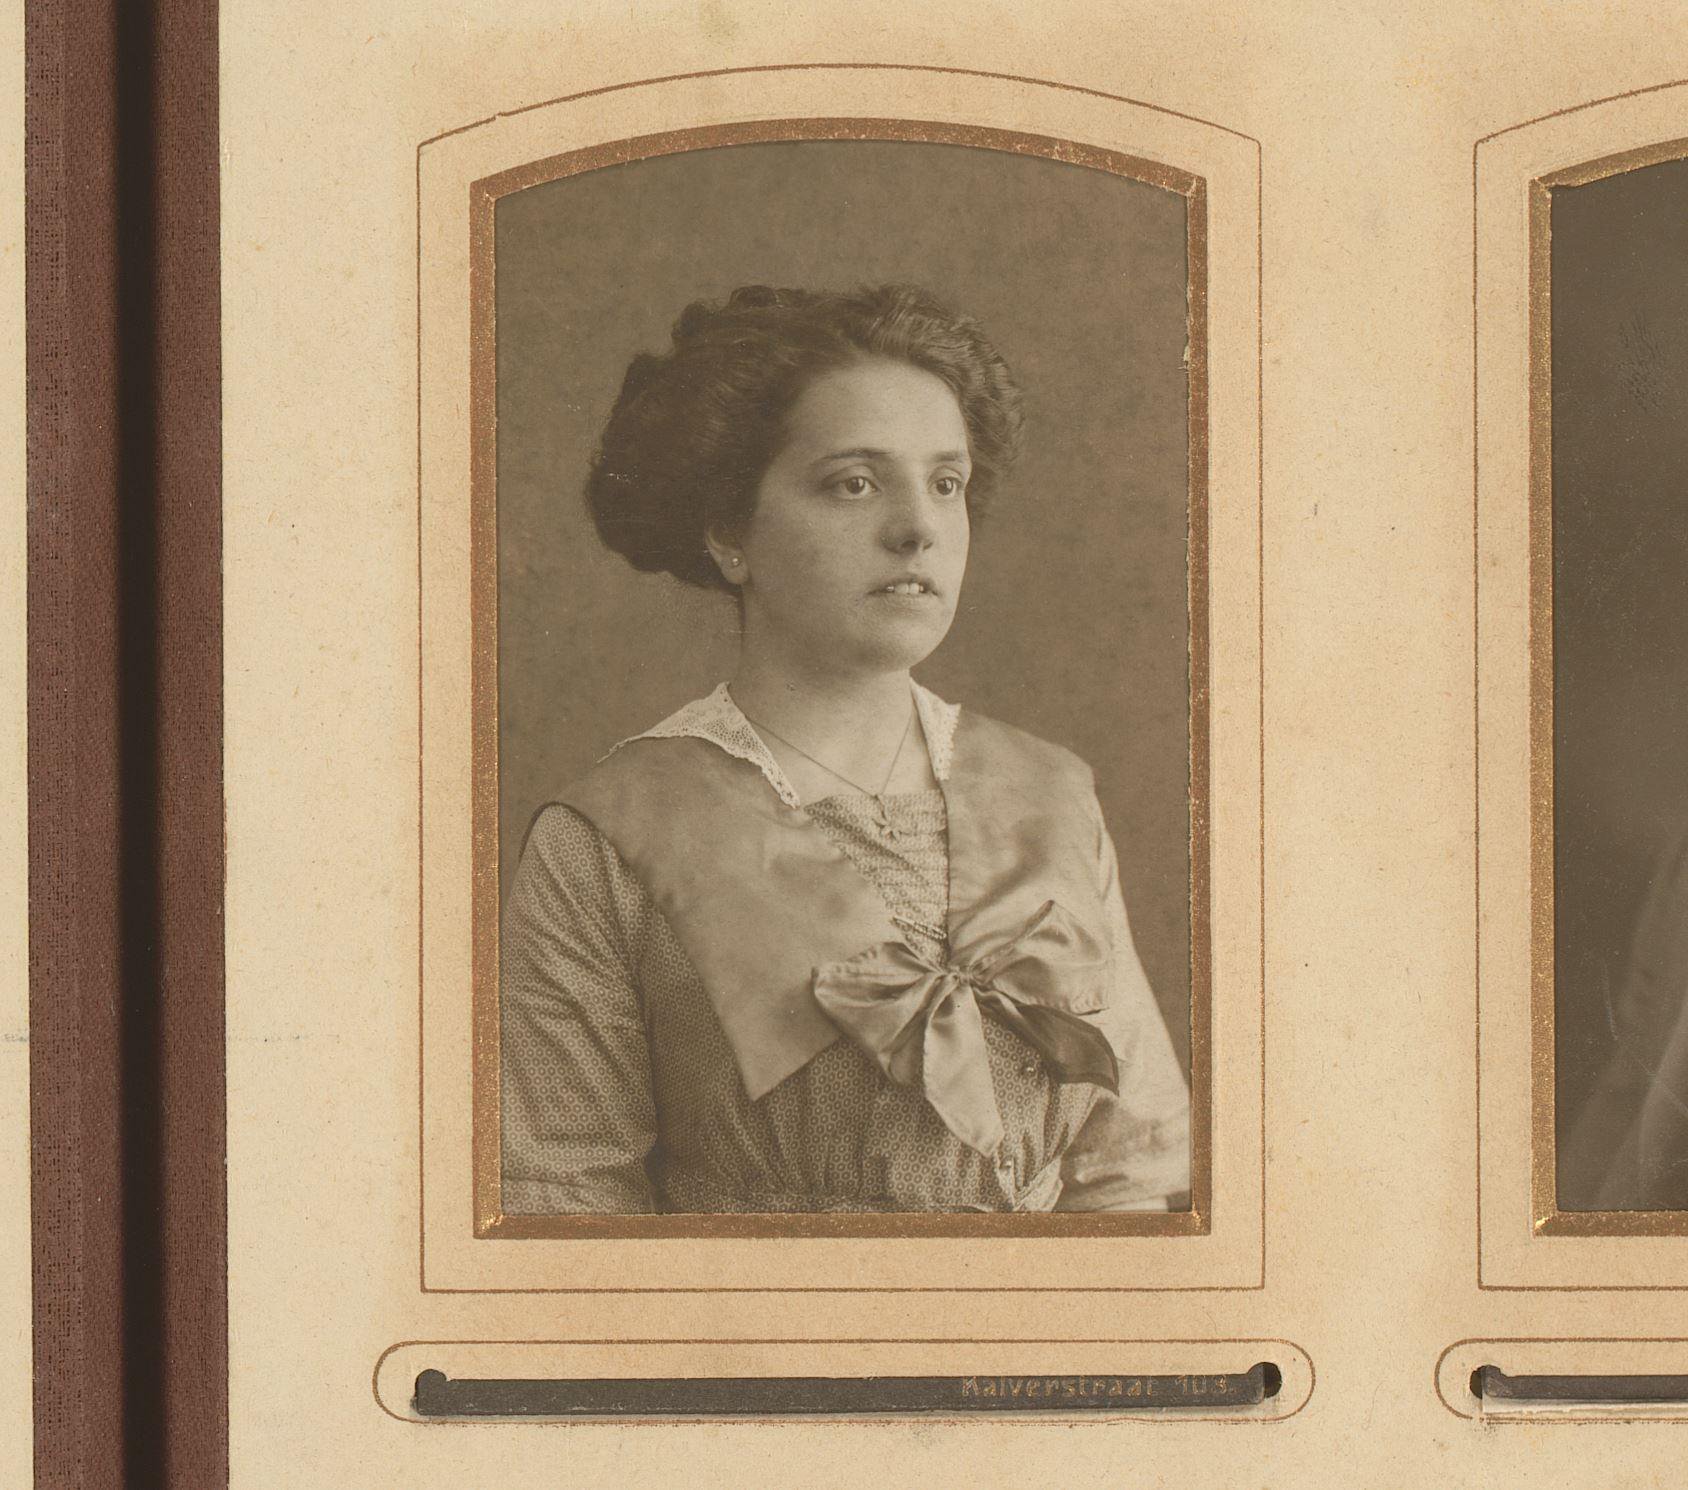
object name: carte de visite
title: Portret van een vrouw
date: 1911-1914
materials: cardboard, photographic support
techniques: collodion silver print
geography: amsterdam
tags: historical persons - bb - woman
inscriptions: inscription: ‘Atelier Prinses/ Amsterdam/ Kalverstraat 103’